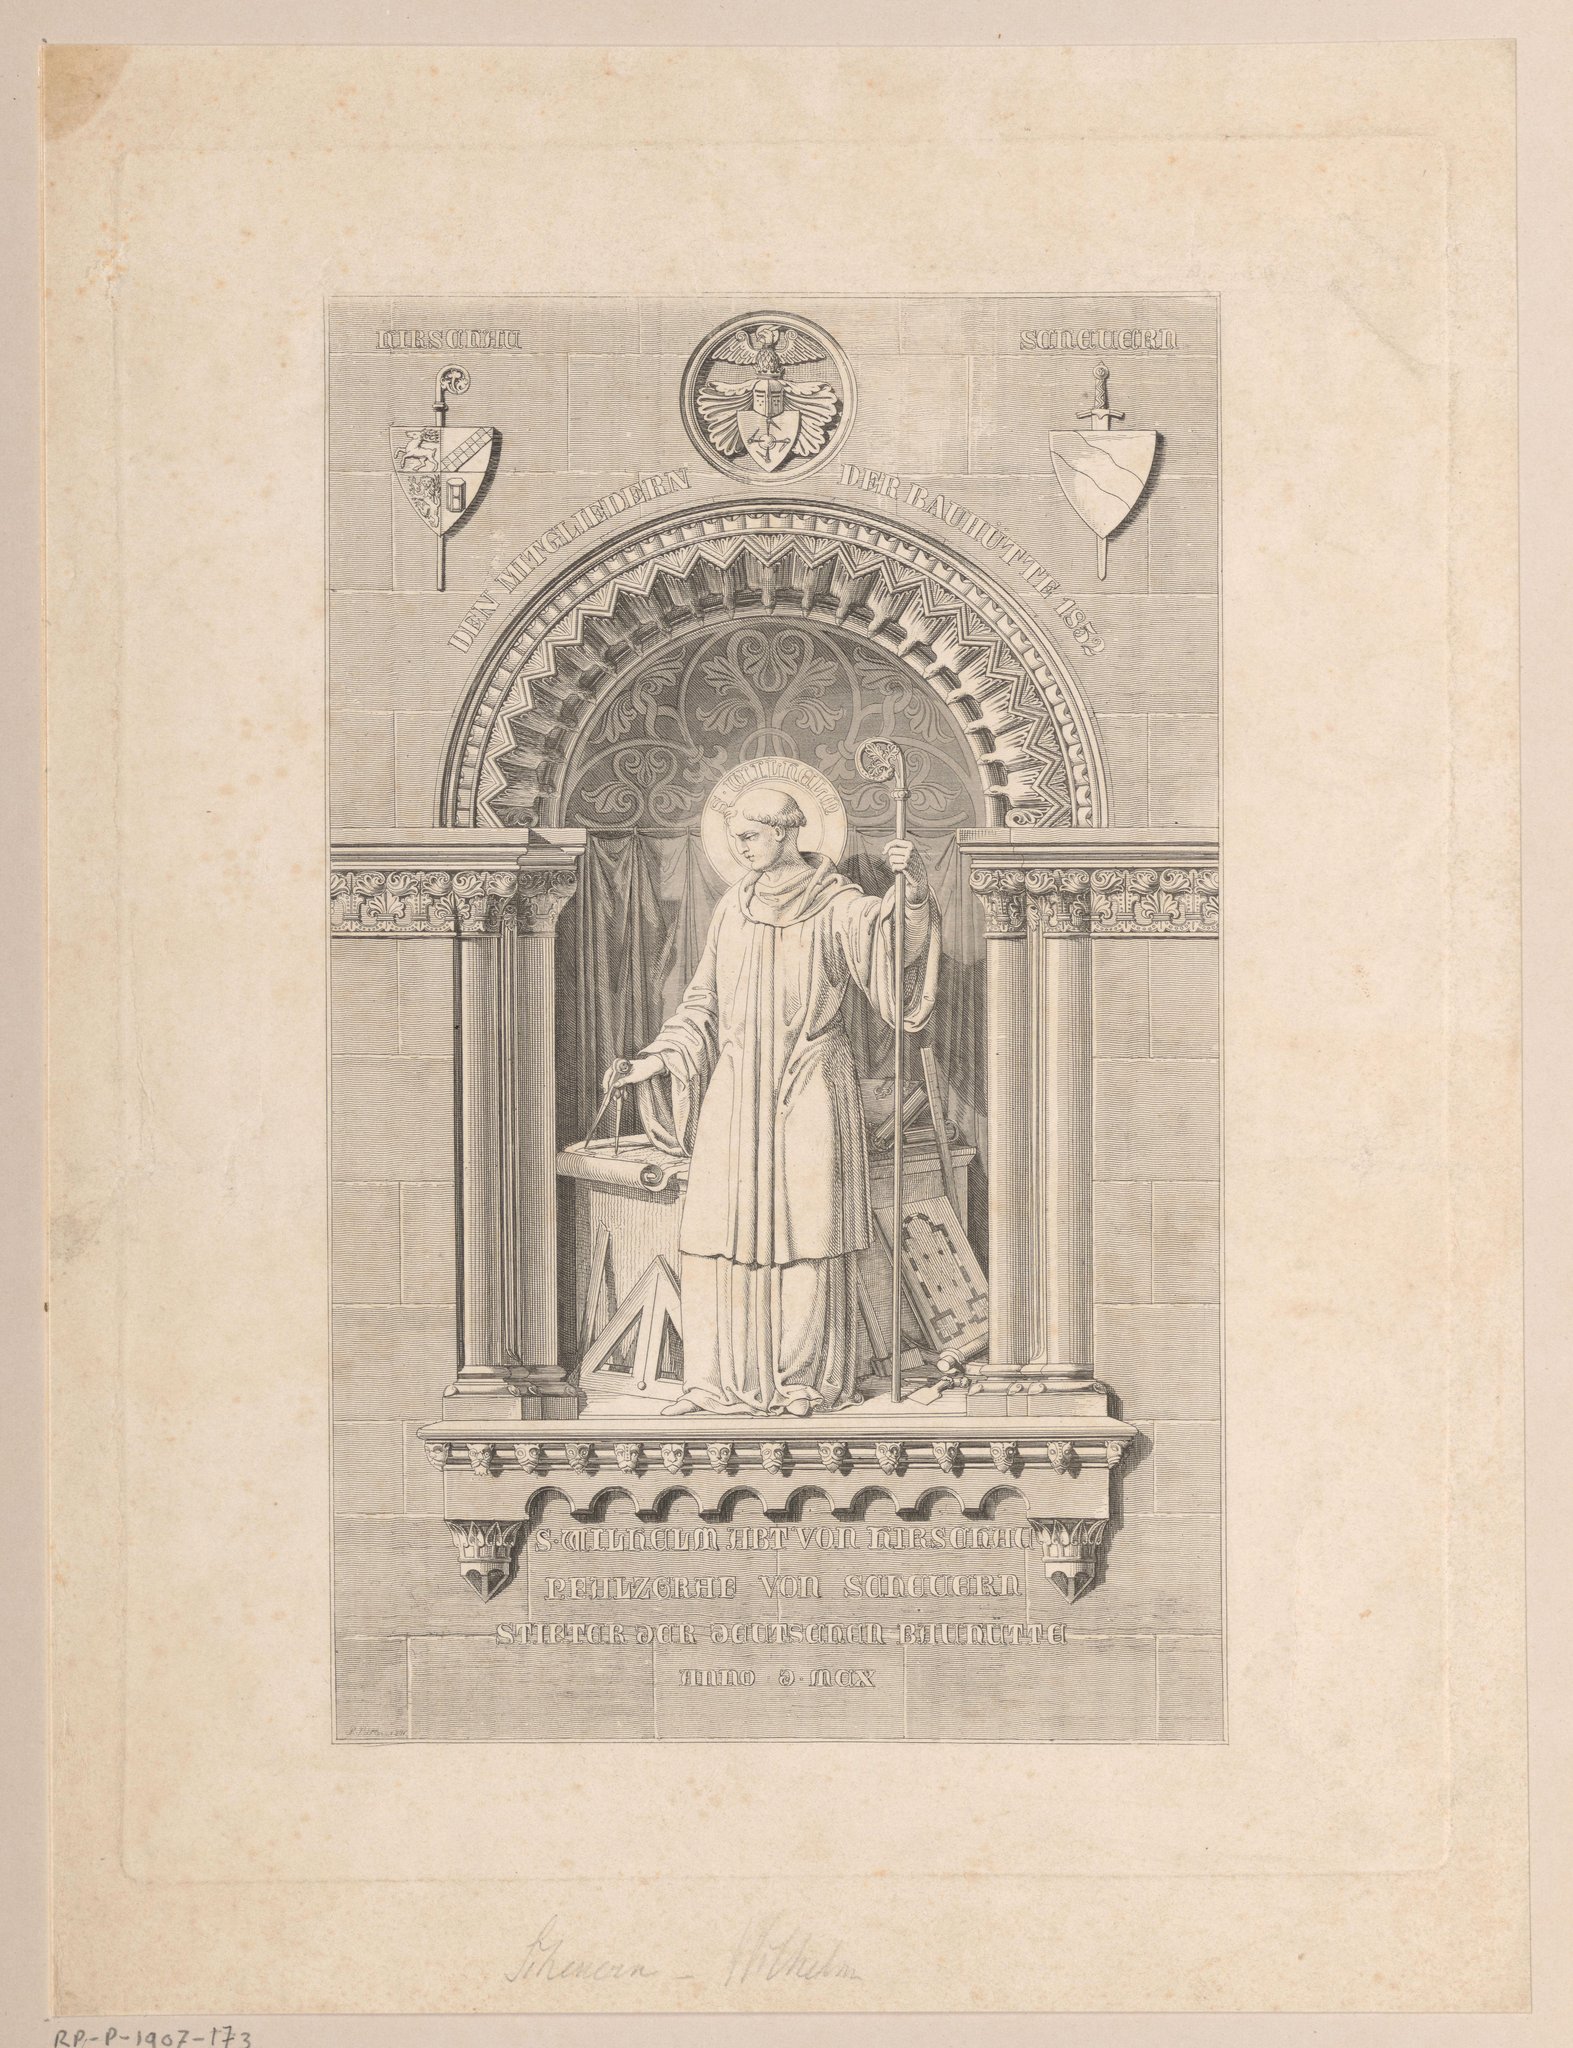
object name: print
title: Portret van de heilige Wilhelm von Hirsau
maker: p. ritter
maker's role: print maker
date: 1851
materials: paper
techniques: etching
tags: building materials, historical persons, saints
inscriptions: collector's mark: Lugt 2228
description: In een nis met achter hem enkele bouwkundige gereedschappen op een tafel.